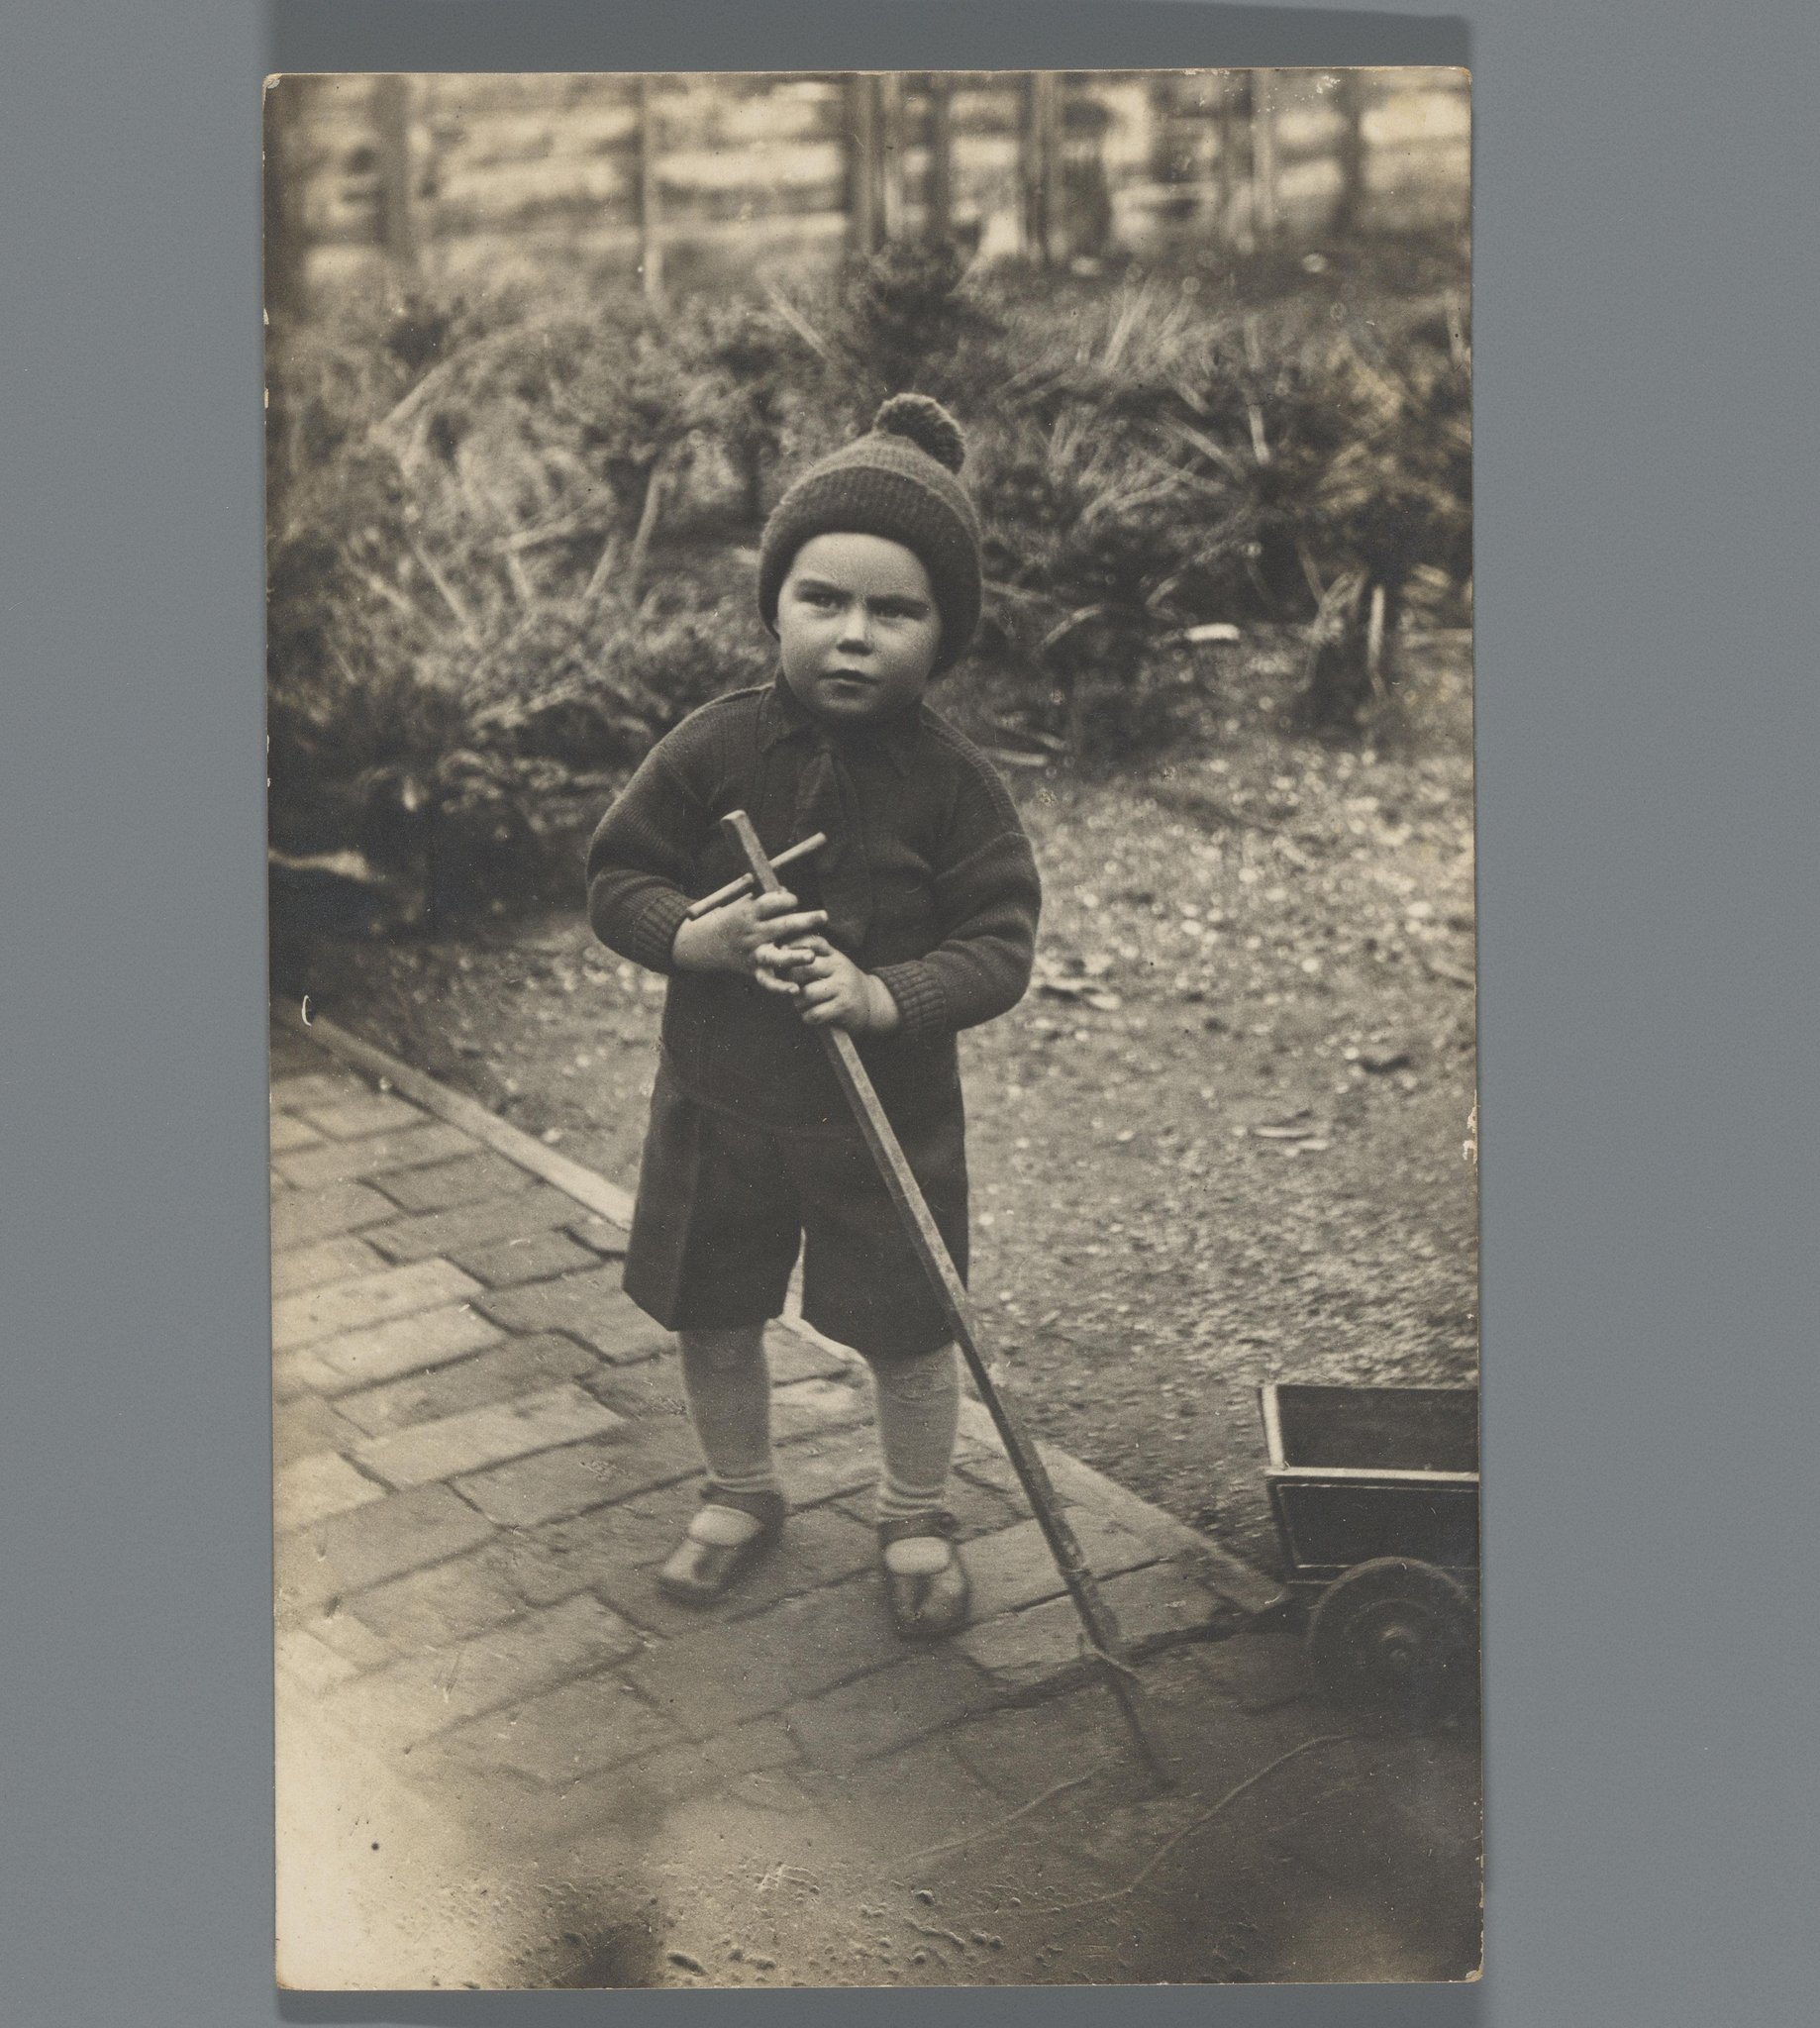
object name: ansichtkaart, prentbriefkaart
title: Portret van een onbekend kind in een tuin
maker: Anonymous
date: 1900-1905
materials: paper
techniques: gelatin silver print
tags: toddler, anonymous historical person portrayed